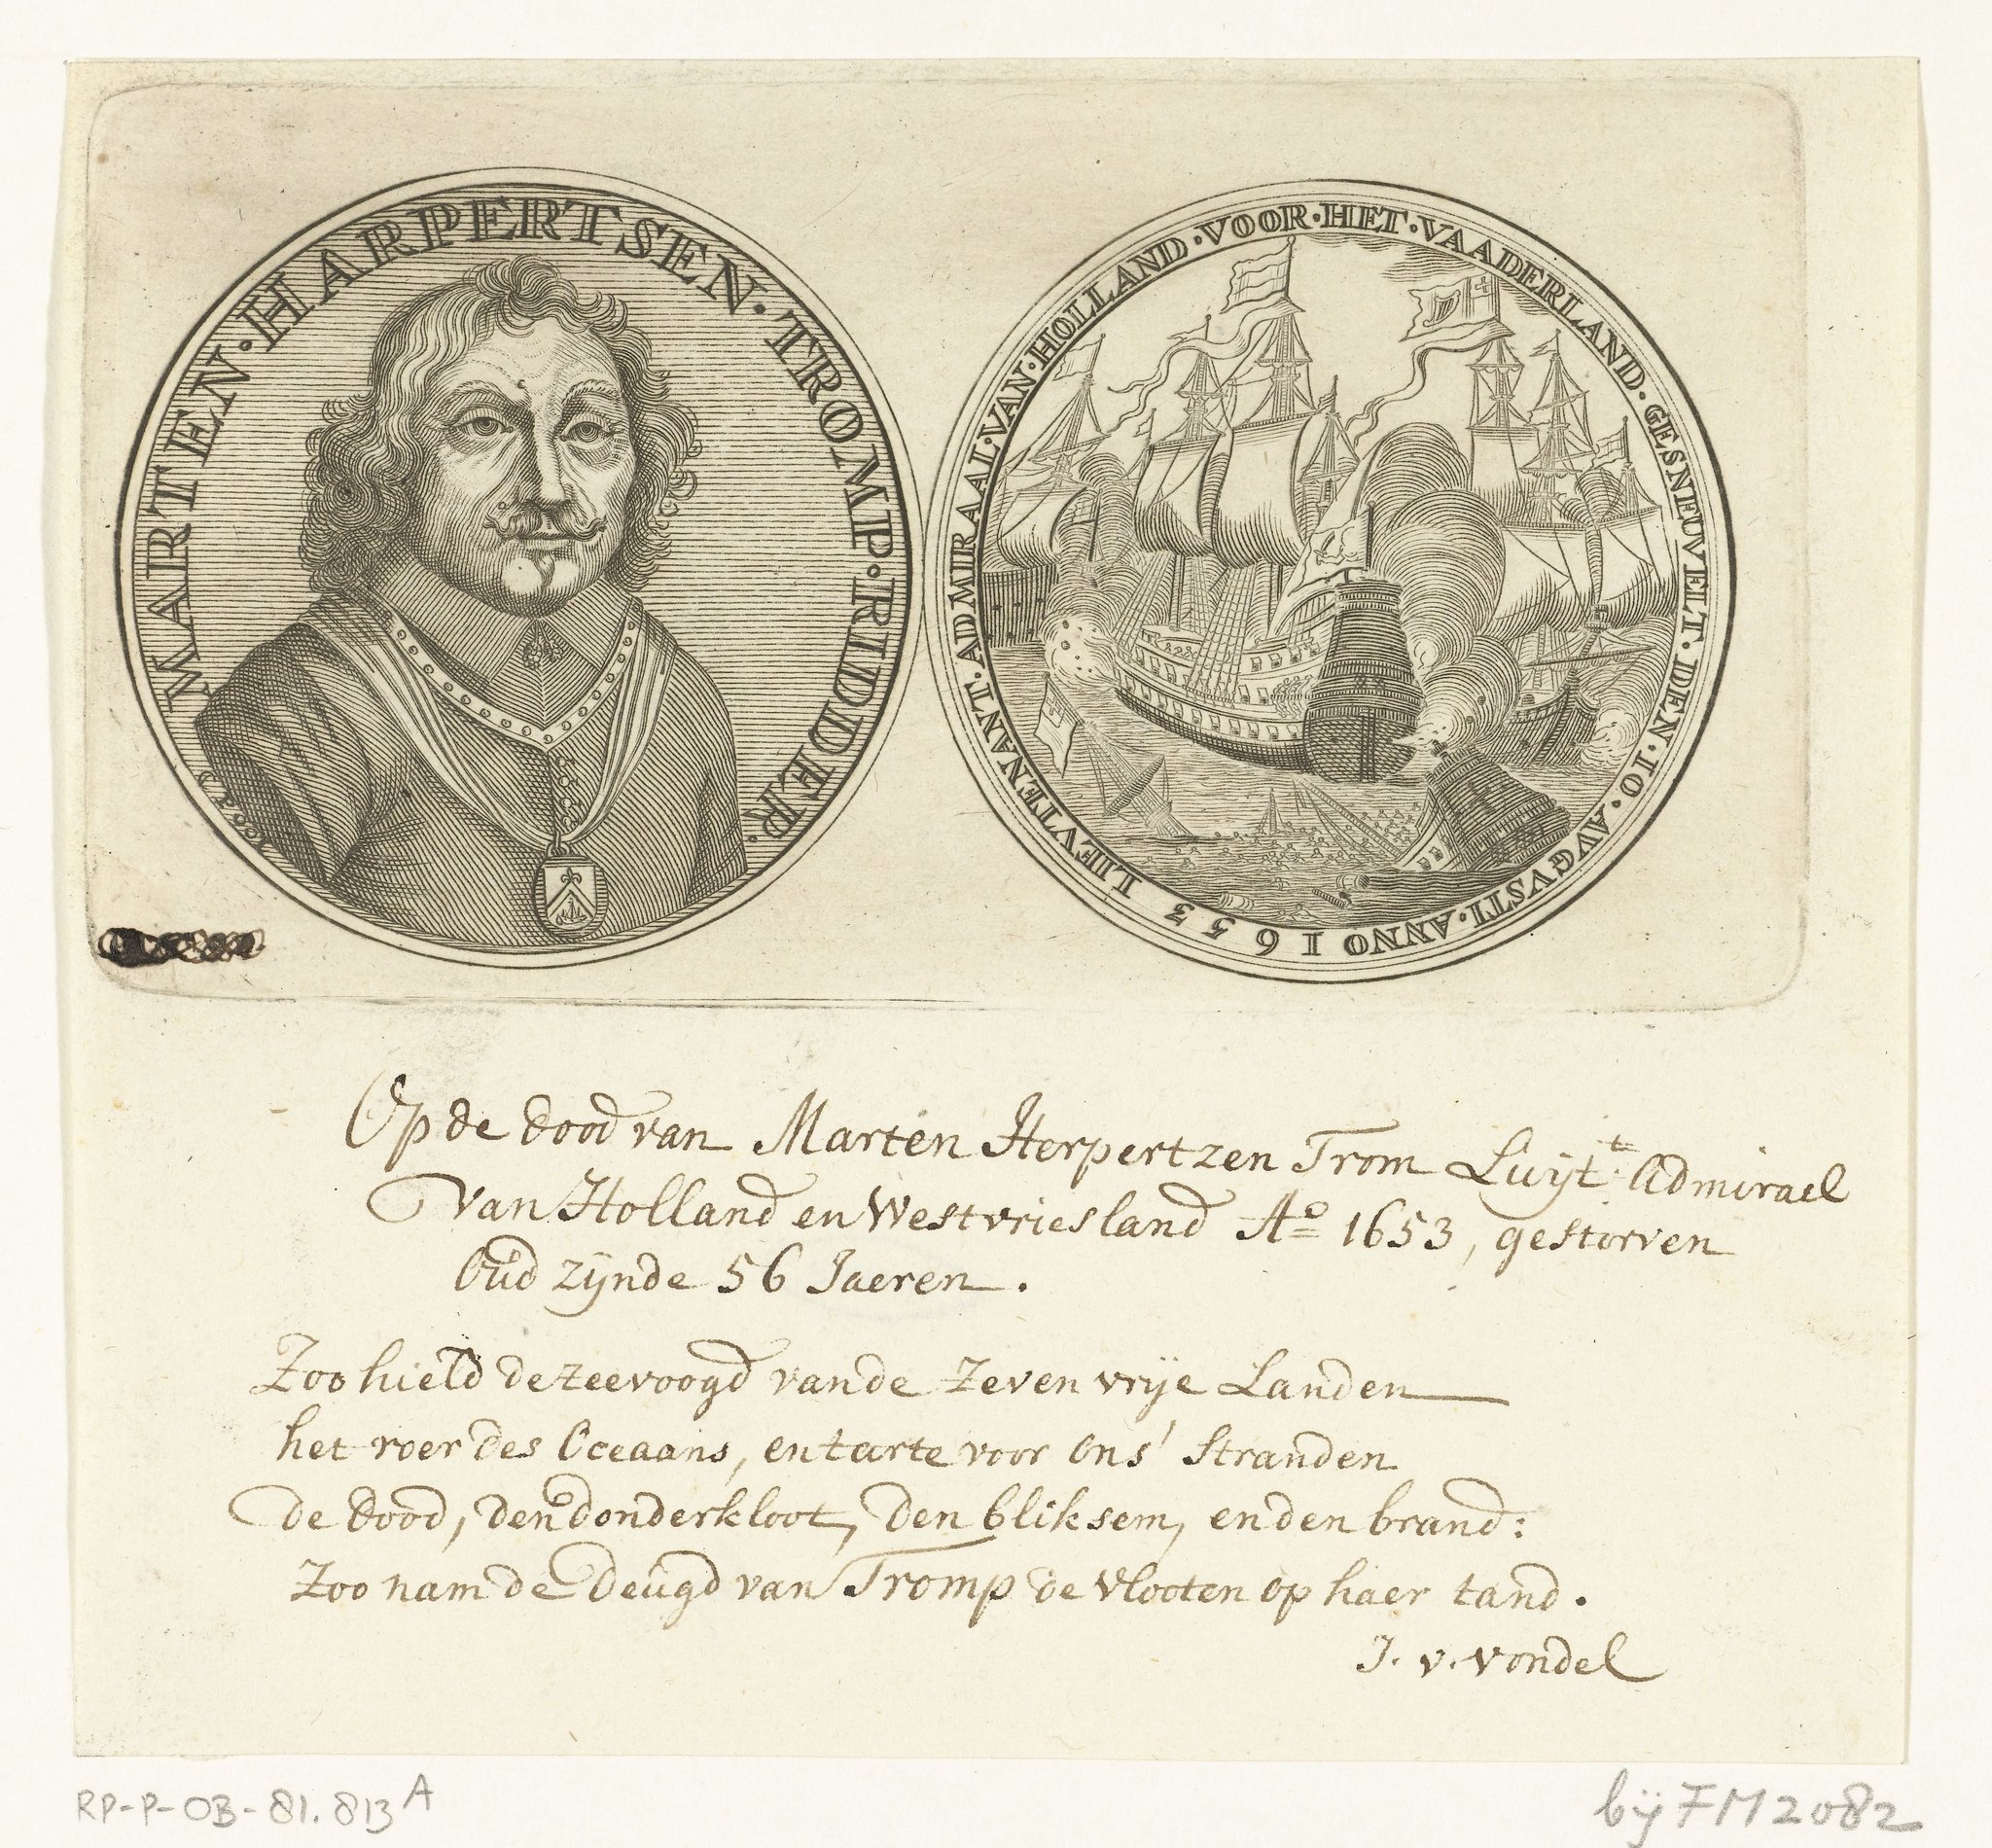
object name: print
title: Penning ter ere van Maarten Tromp, gesneuveld in de Zeeslag bij Terheide, 1653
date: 1653-1749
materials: paper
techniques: engraving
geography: northern netherlands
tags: brielle, maarten harpertszoon tromp, medal (considered as a piece of sculpture, regardless of its specific function), battle of scheveningen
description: Penning ter ere van admiraal Maarten Tromp, gesneuveld in de zeeslag bij Terheide op 10 augustus 1653. Zilveren penning. Voorzijde: portret van Tromp binnen omschrift. Keerzijde: Zeeslag bij Terheide binnen omschrift. Onder de plaat een afschrift van een gedicht van Vondel op de dood van Tromp.